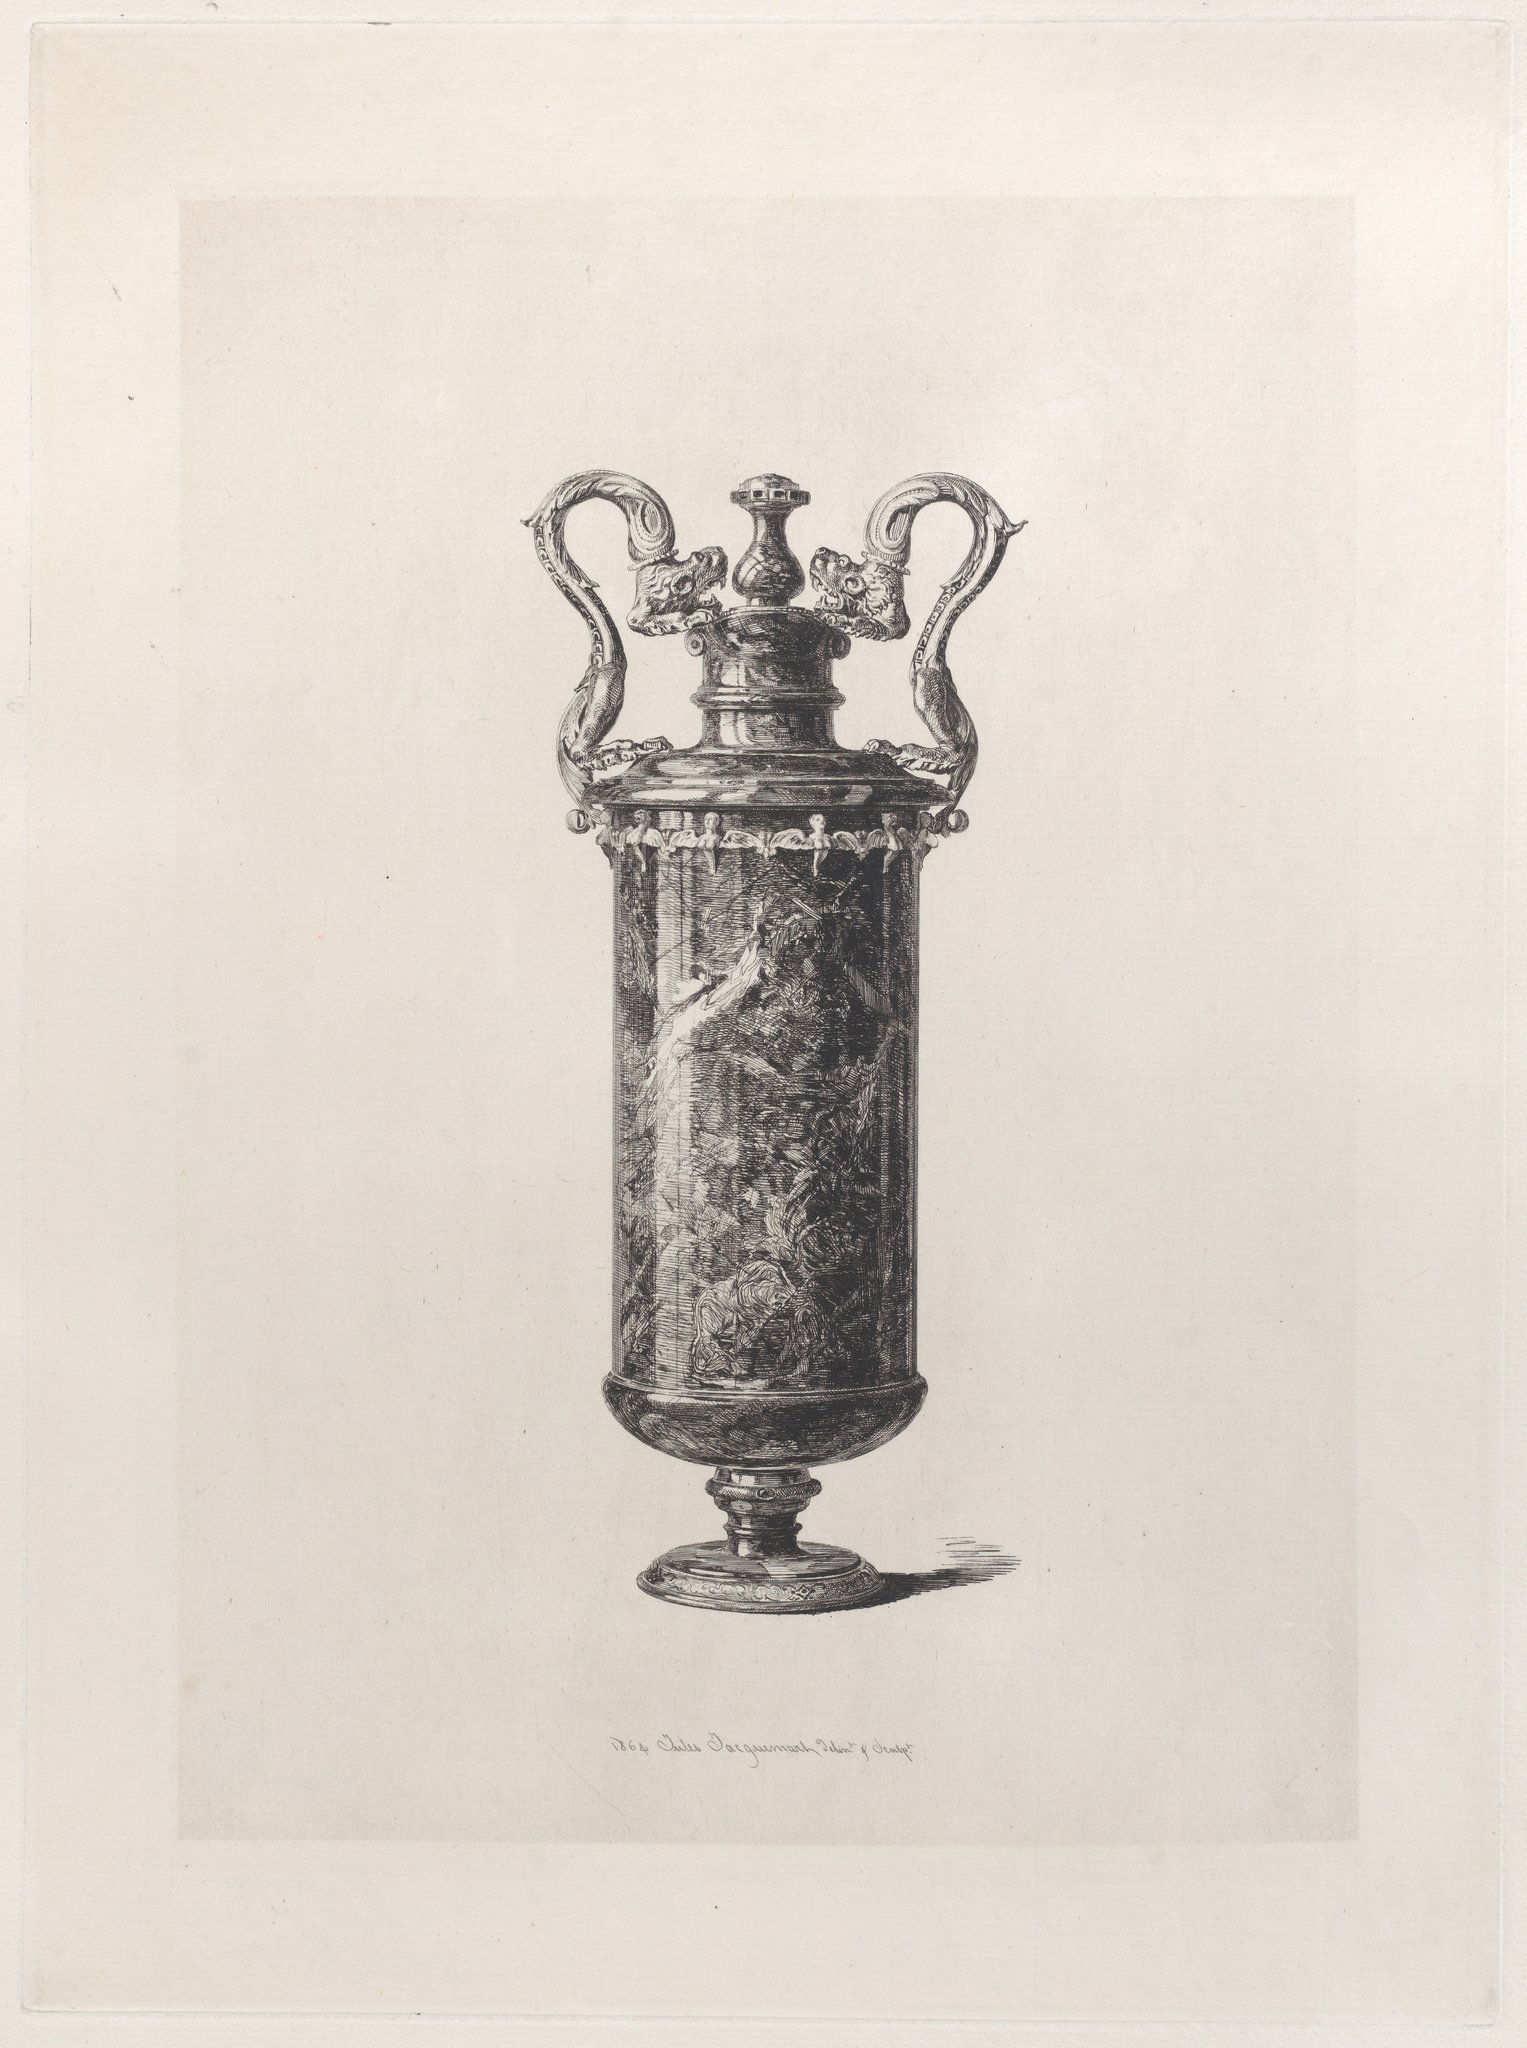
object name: print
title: Oriental Jasper Vase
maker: jules-ferdinand jacquemart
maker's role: artist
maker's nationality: french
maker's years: 1837-1880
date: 1864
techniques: etching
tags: vases